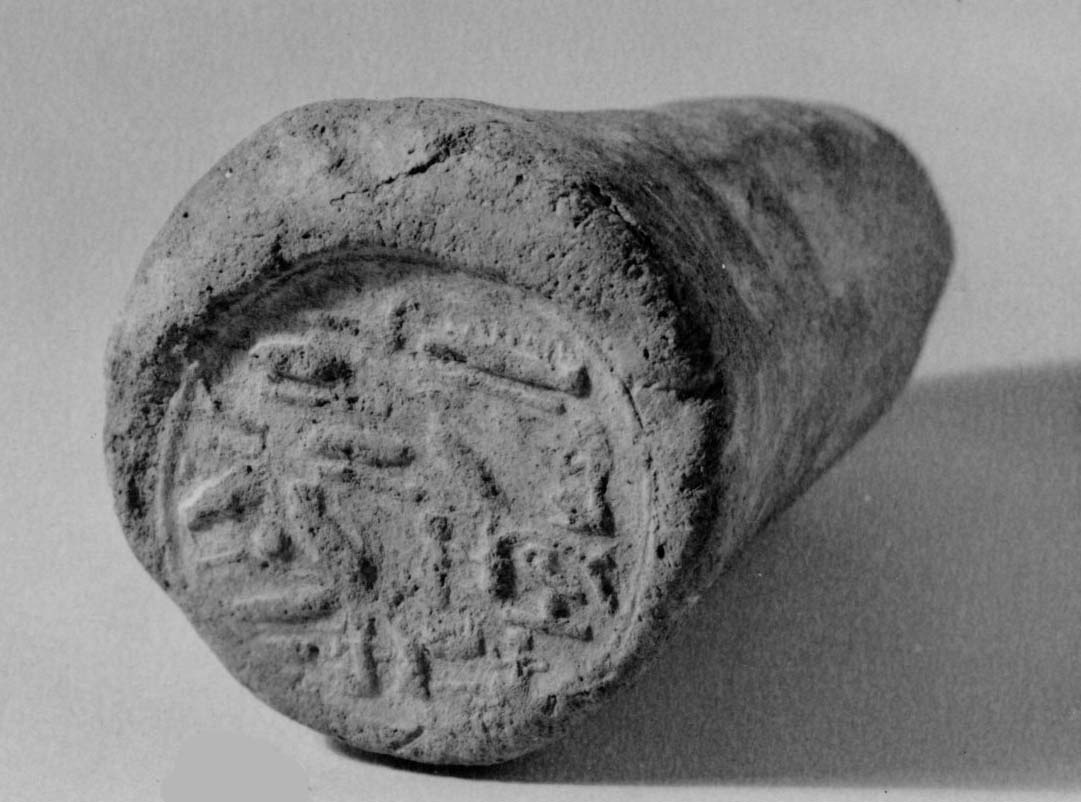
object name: cone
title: Funerary Cone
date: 1550-1295 BCE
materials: pottery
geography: egypt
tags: hieroglyphs